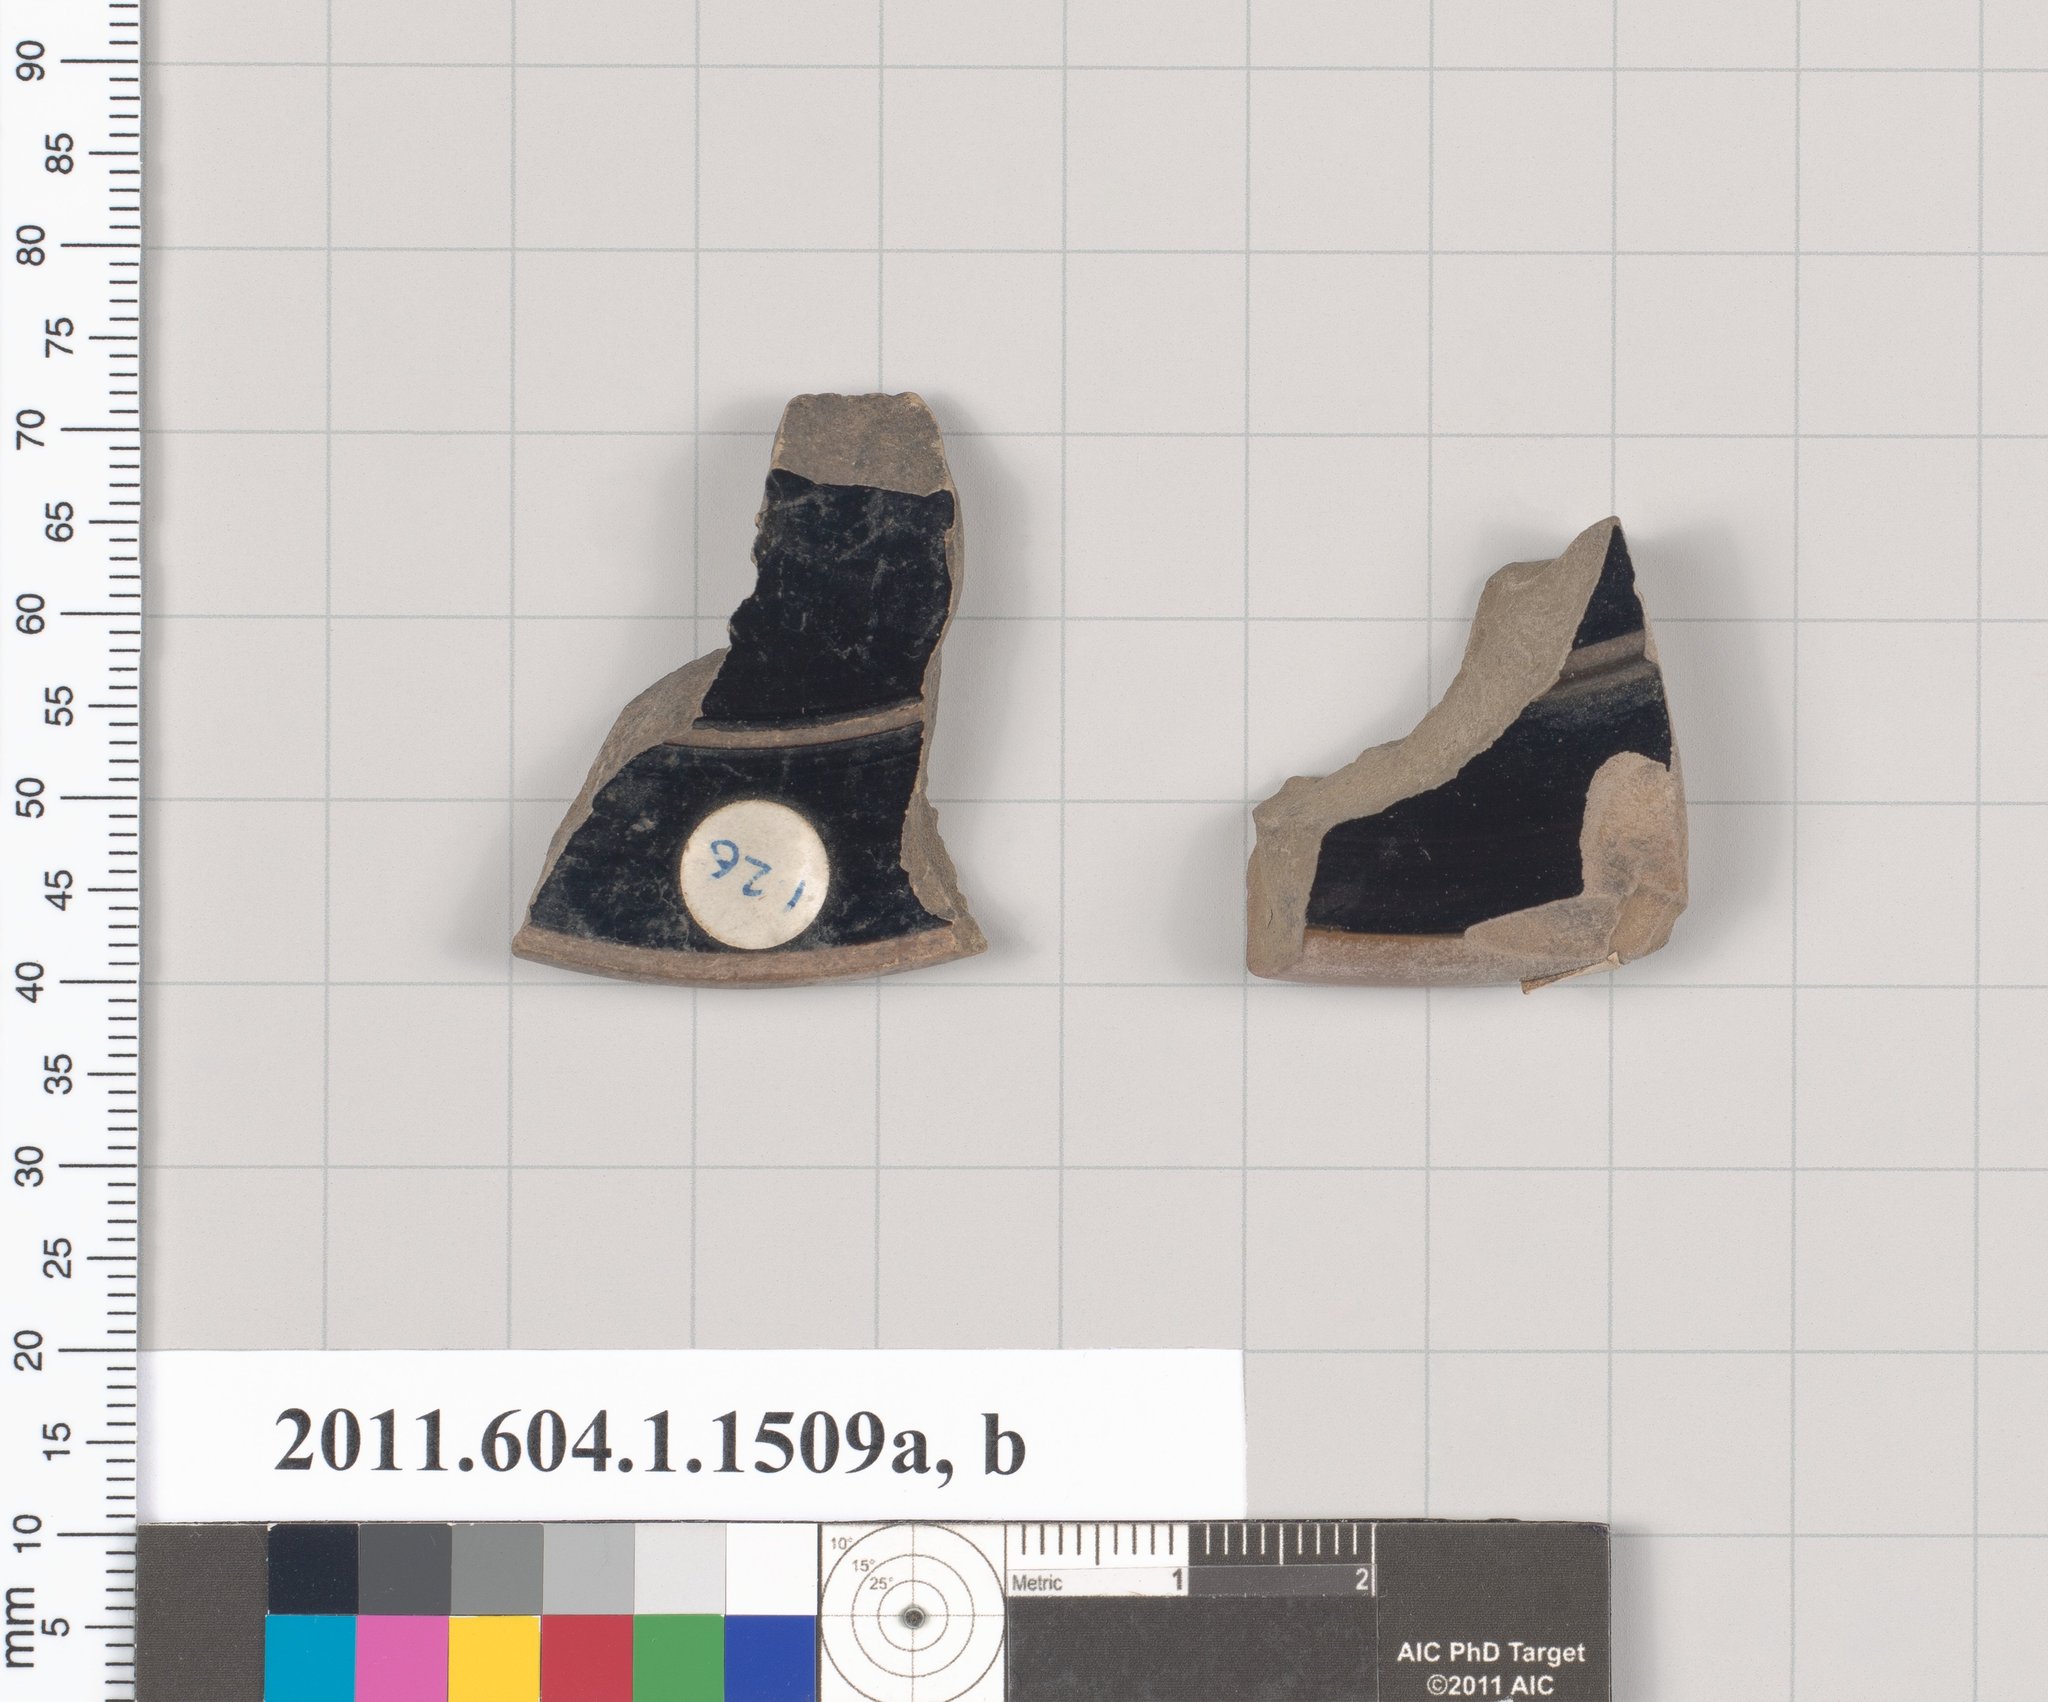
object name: kylix fragment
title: Terracotta fragments of kylikes (drinking cups)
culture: greek, attic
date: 500-401 BCE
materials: terracotta